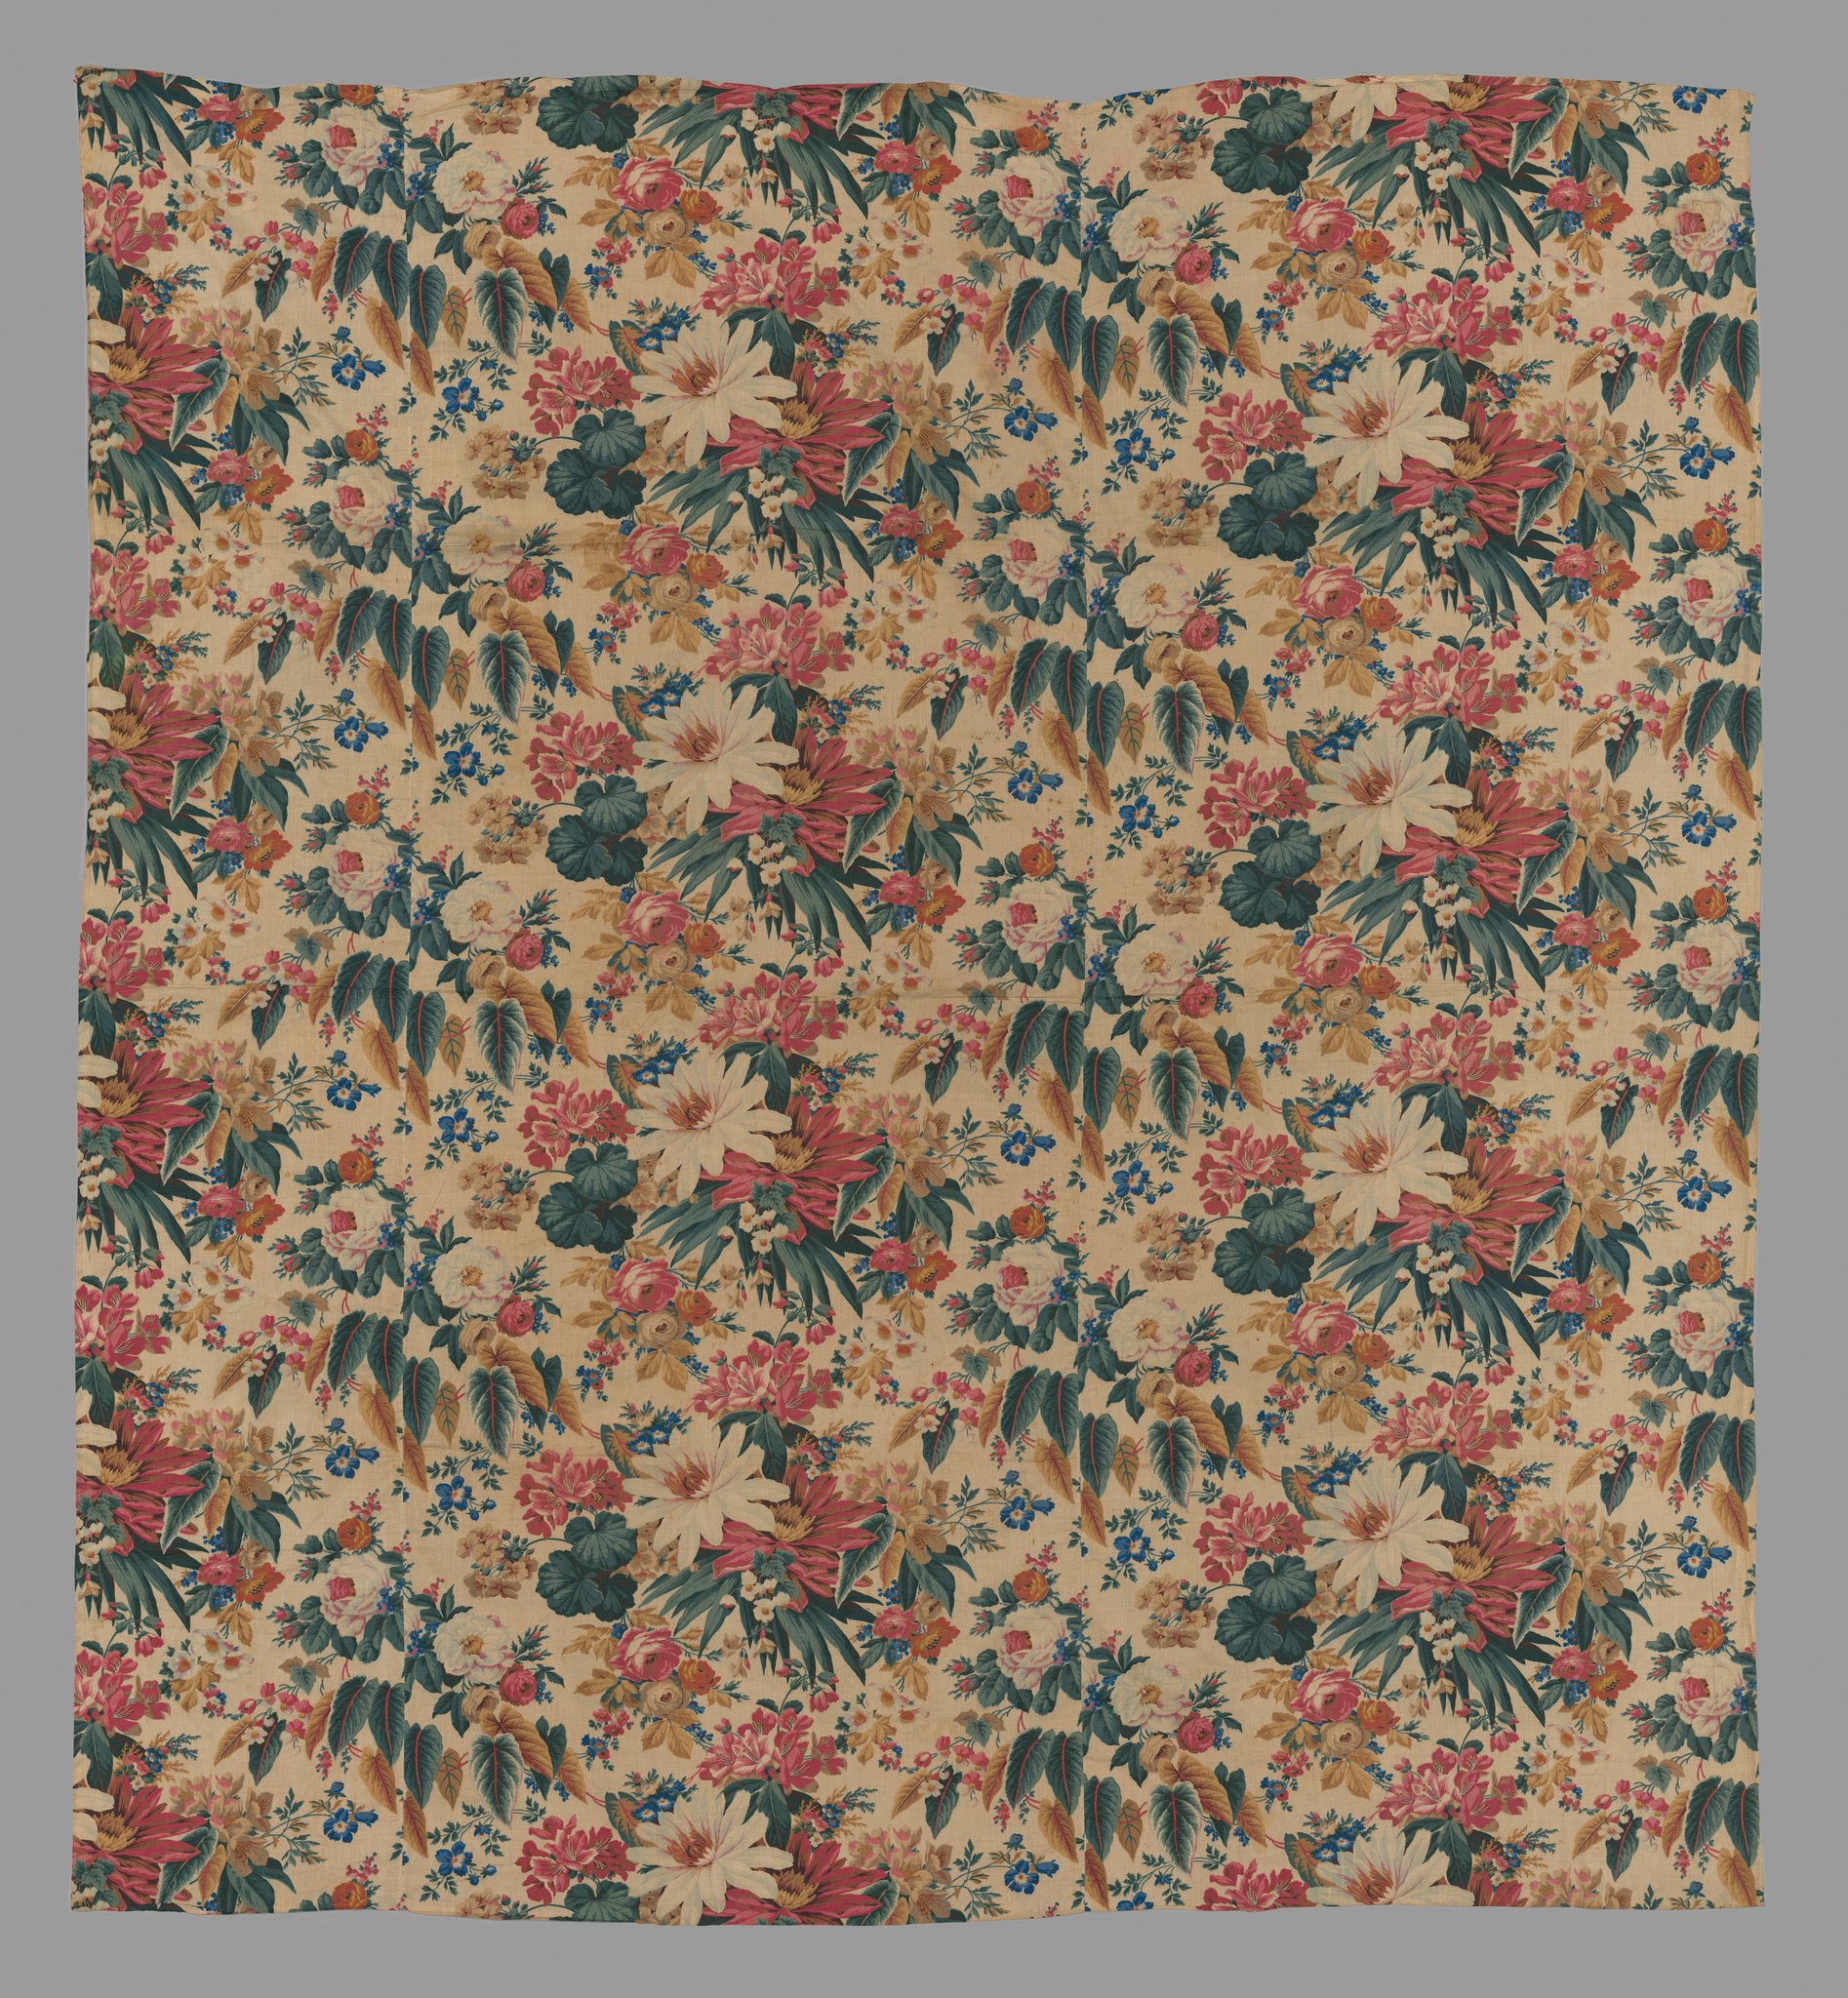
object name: length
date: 1840-1859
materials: cotton